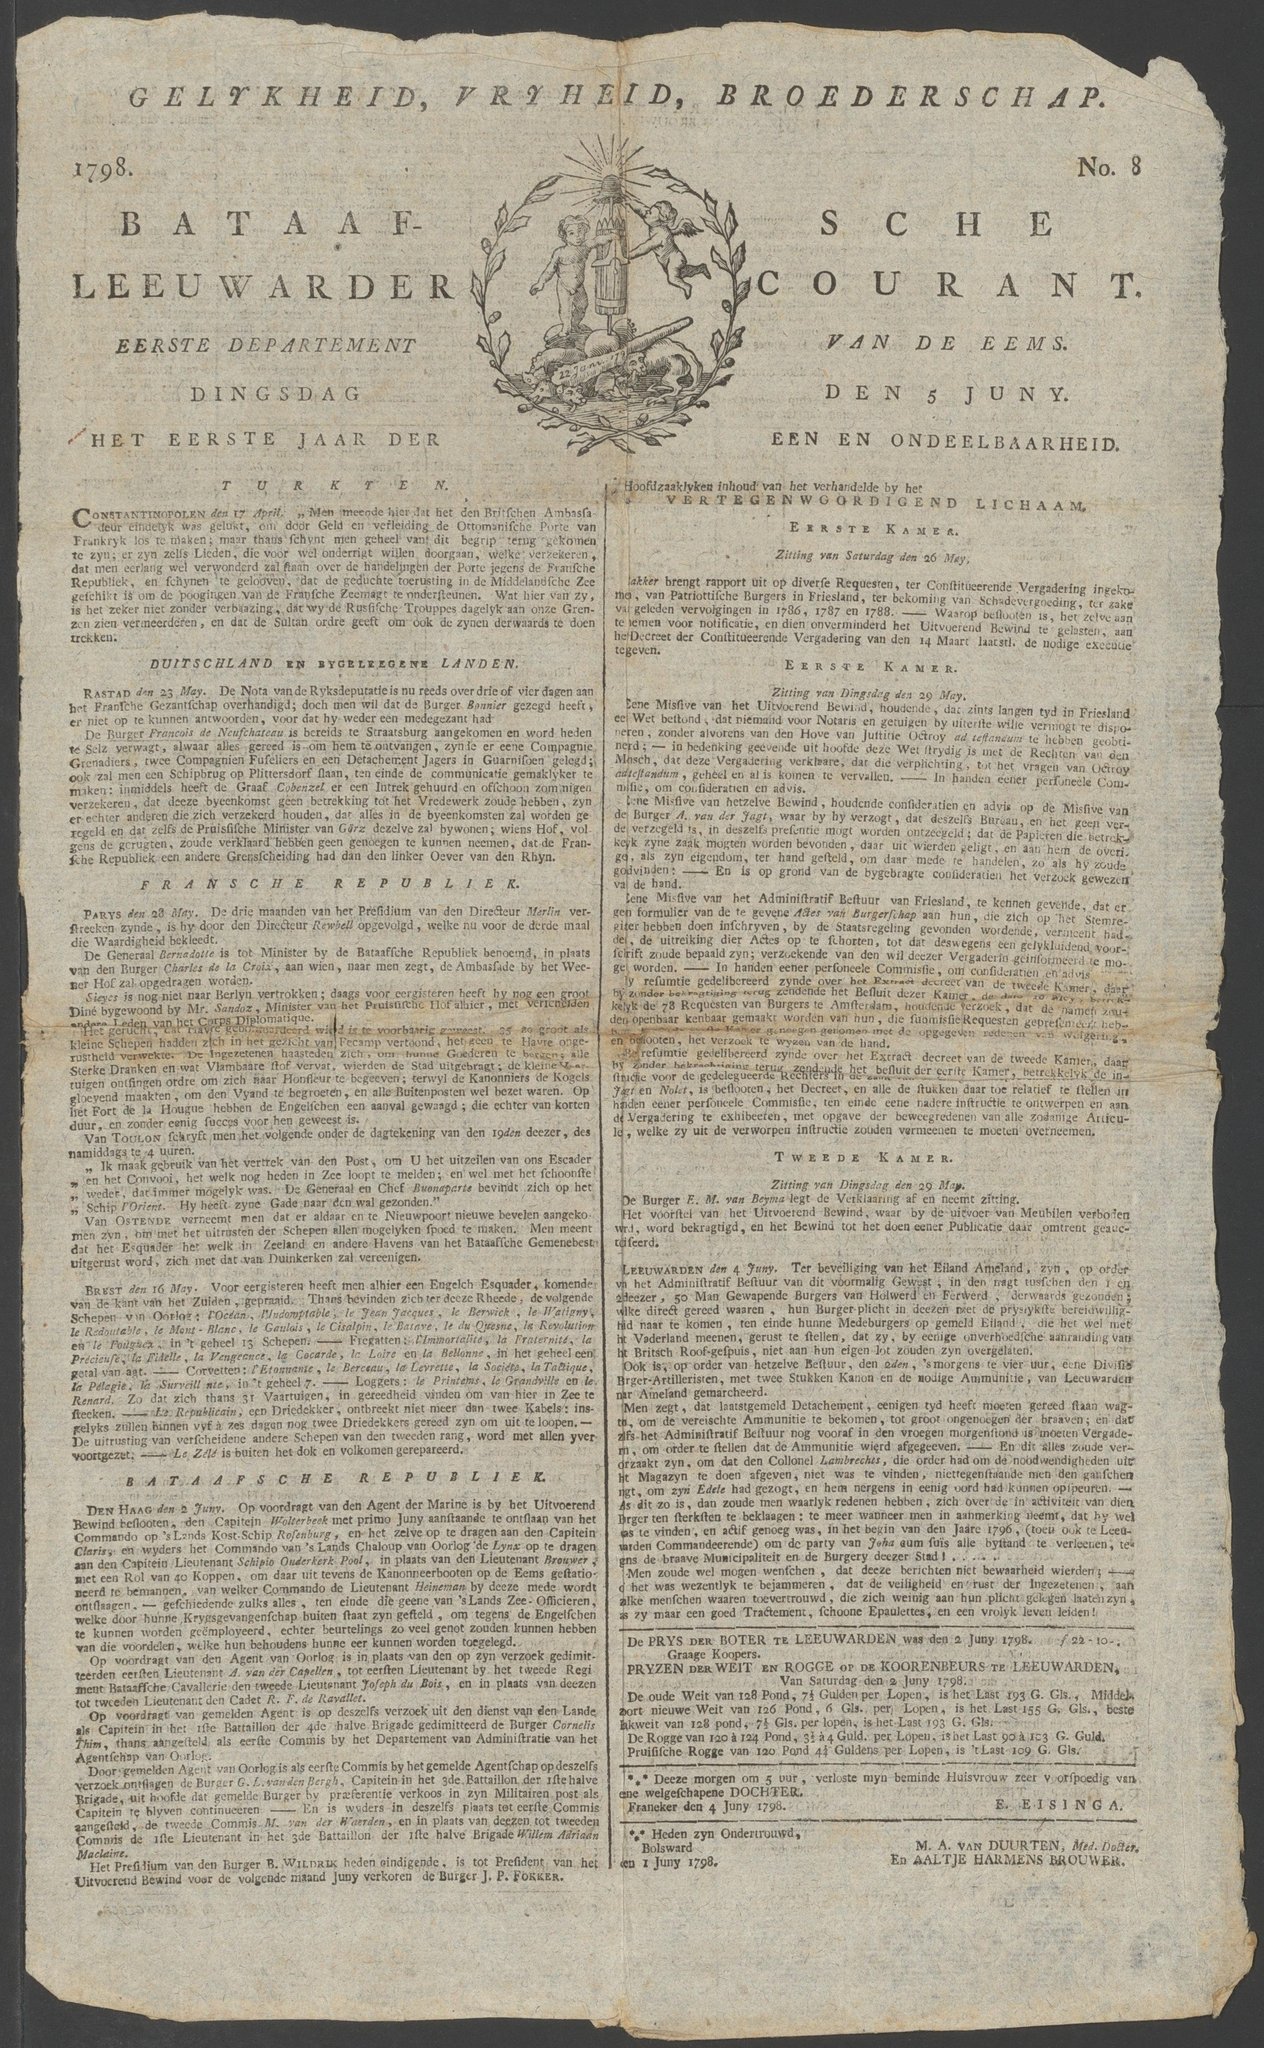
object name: newspaper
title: Bataafsche Leeuwarder Courant, 5 juni 1798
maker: matthys koon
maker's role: printer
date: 1798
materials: paper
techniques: letterpress printing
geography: leeuwarden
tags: newspaper, news-sheet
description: Exemplaar van de krant 'Bataafsche Leeuwarder Courant', 5 juni 1798. Enkelbladig, beide zijden bedrukt. Bovenaan een allegorisch vignet op de vrijheid. Onderwerpsrubrieken binnen de Atlas Zeden en Gewoonten: Regeering, Officieele Nieuwsbladen.